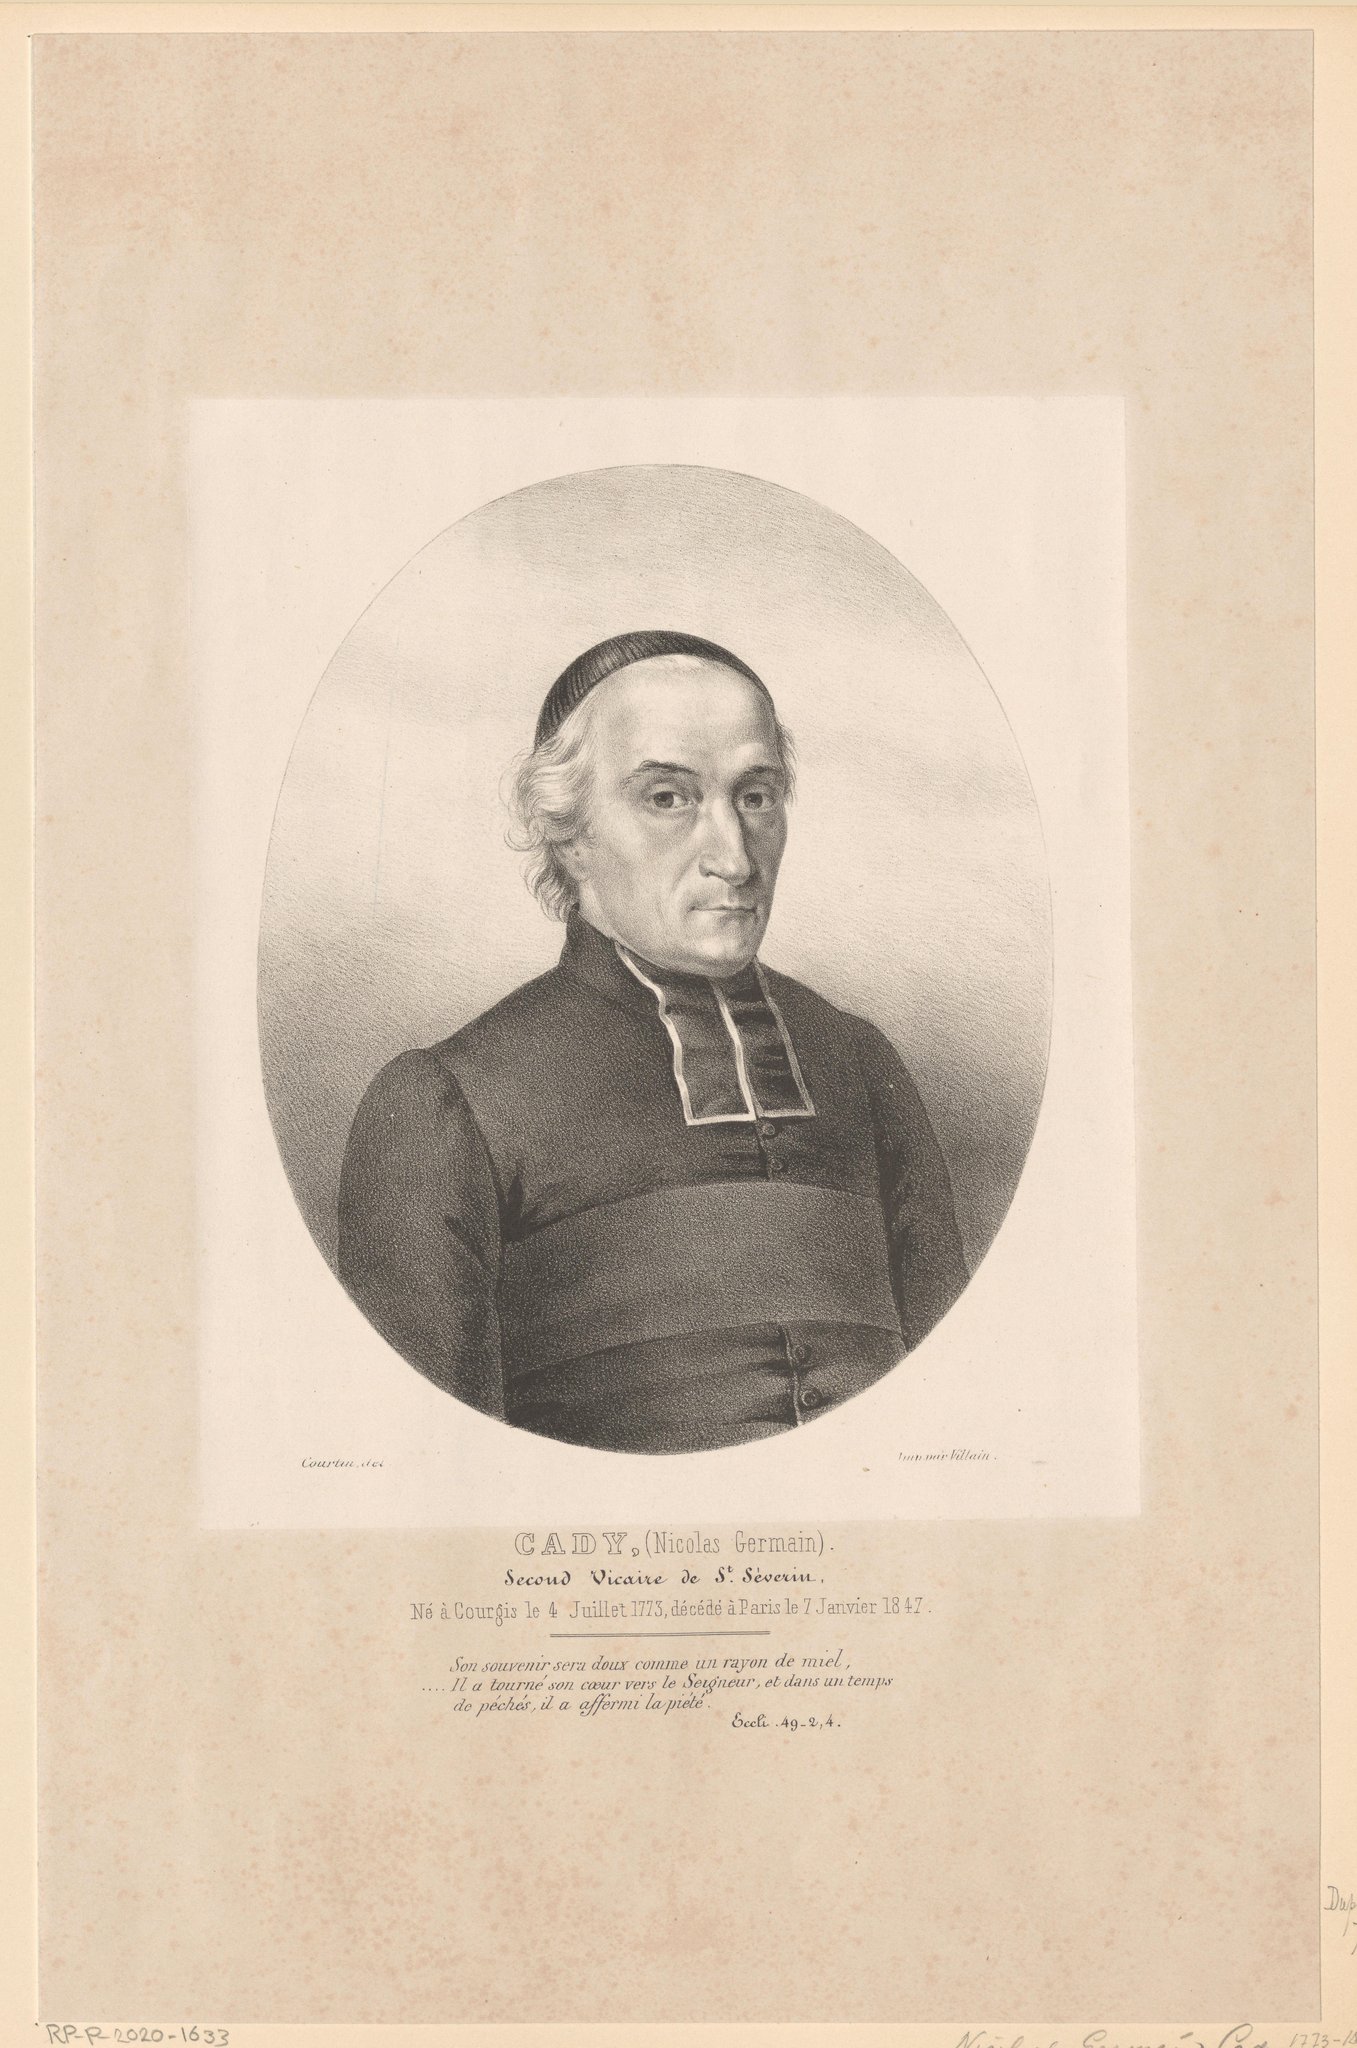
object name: print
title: Portret van Nicolas Germain Cady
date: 1847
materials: paper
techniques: lithograph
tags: historical persons